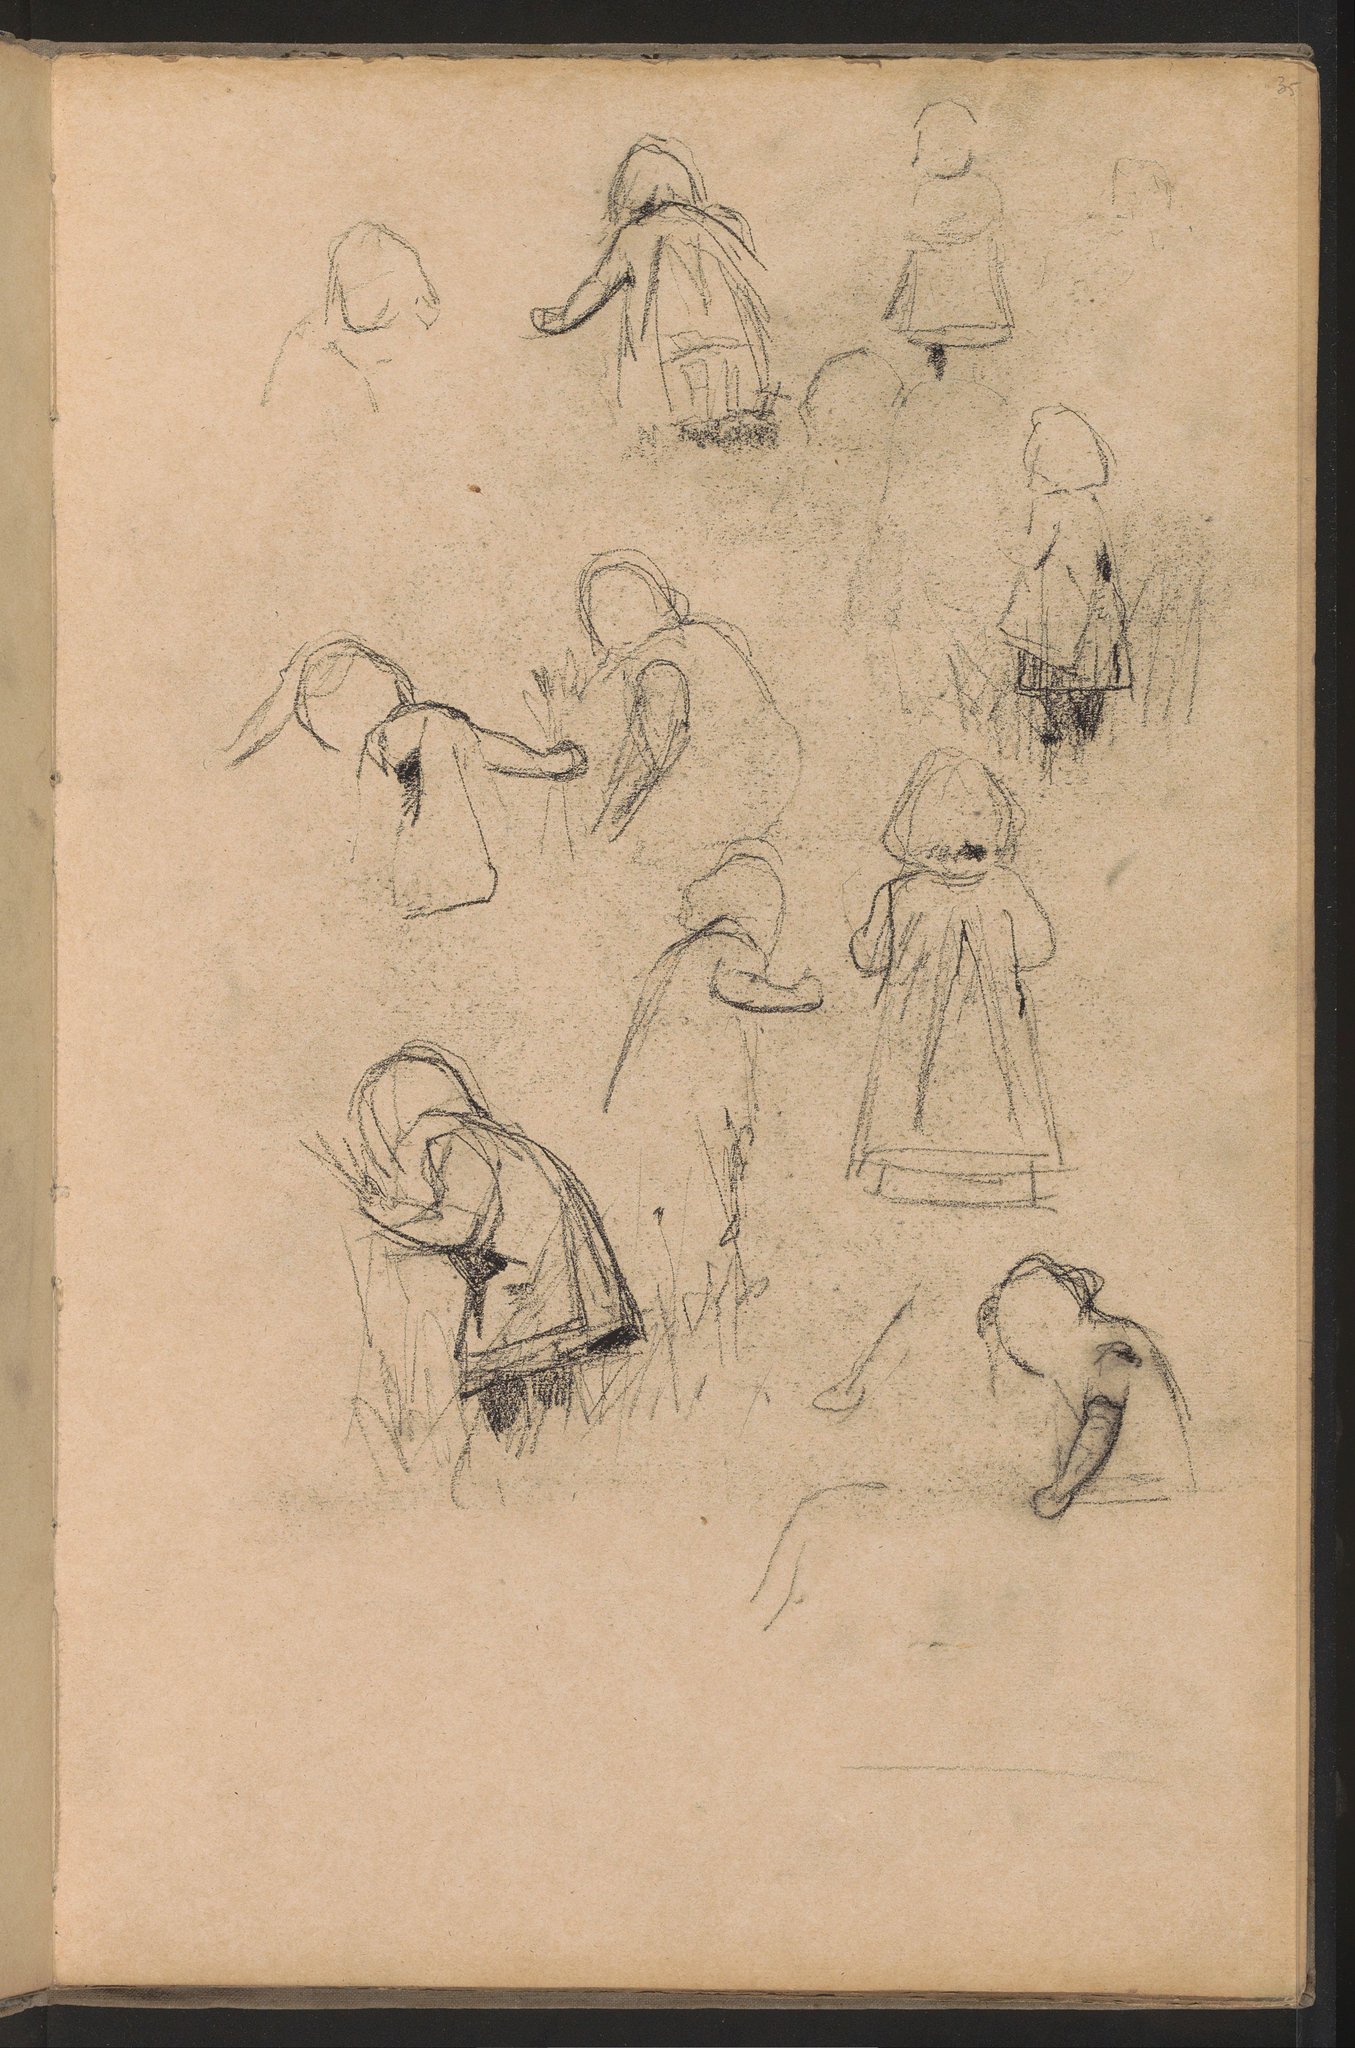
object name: sketchbook leaf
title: Studies van een meisje in het gras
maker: willem witsen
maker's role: draughtsman, painter, print maker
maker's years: 1860-1923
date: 1884-1887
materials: chalk, paper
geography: ewijkshoeve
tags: meadow, pasture, girl (child between toddler and youth)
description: Pagina 35 uit een schetsboek met 45 bladen vervaardigd rond de Ewijkshoeve.